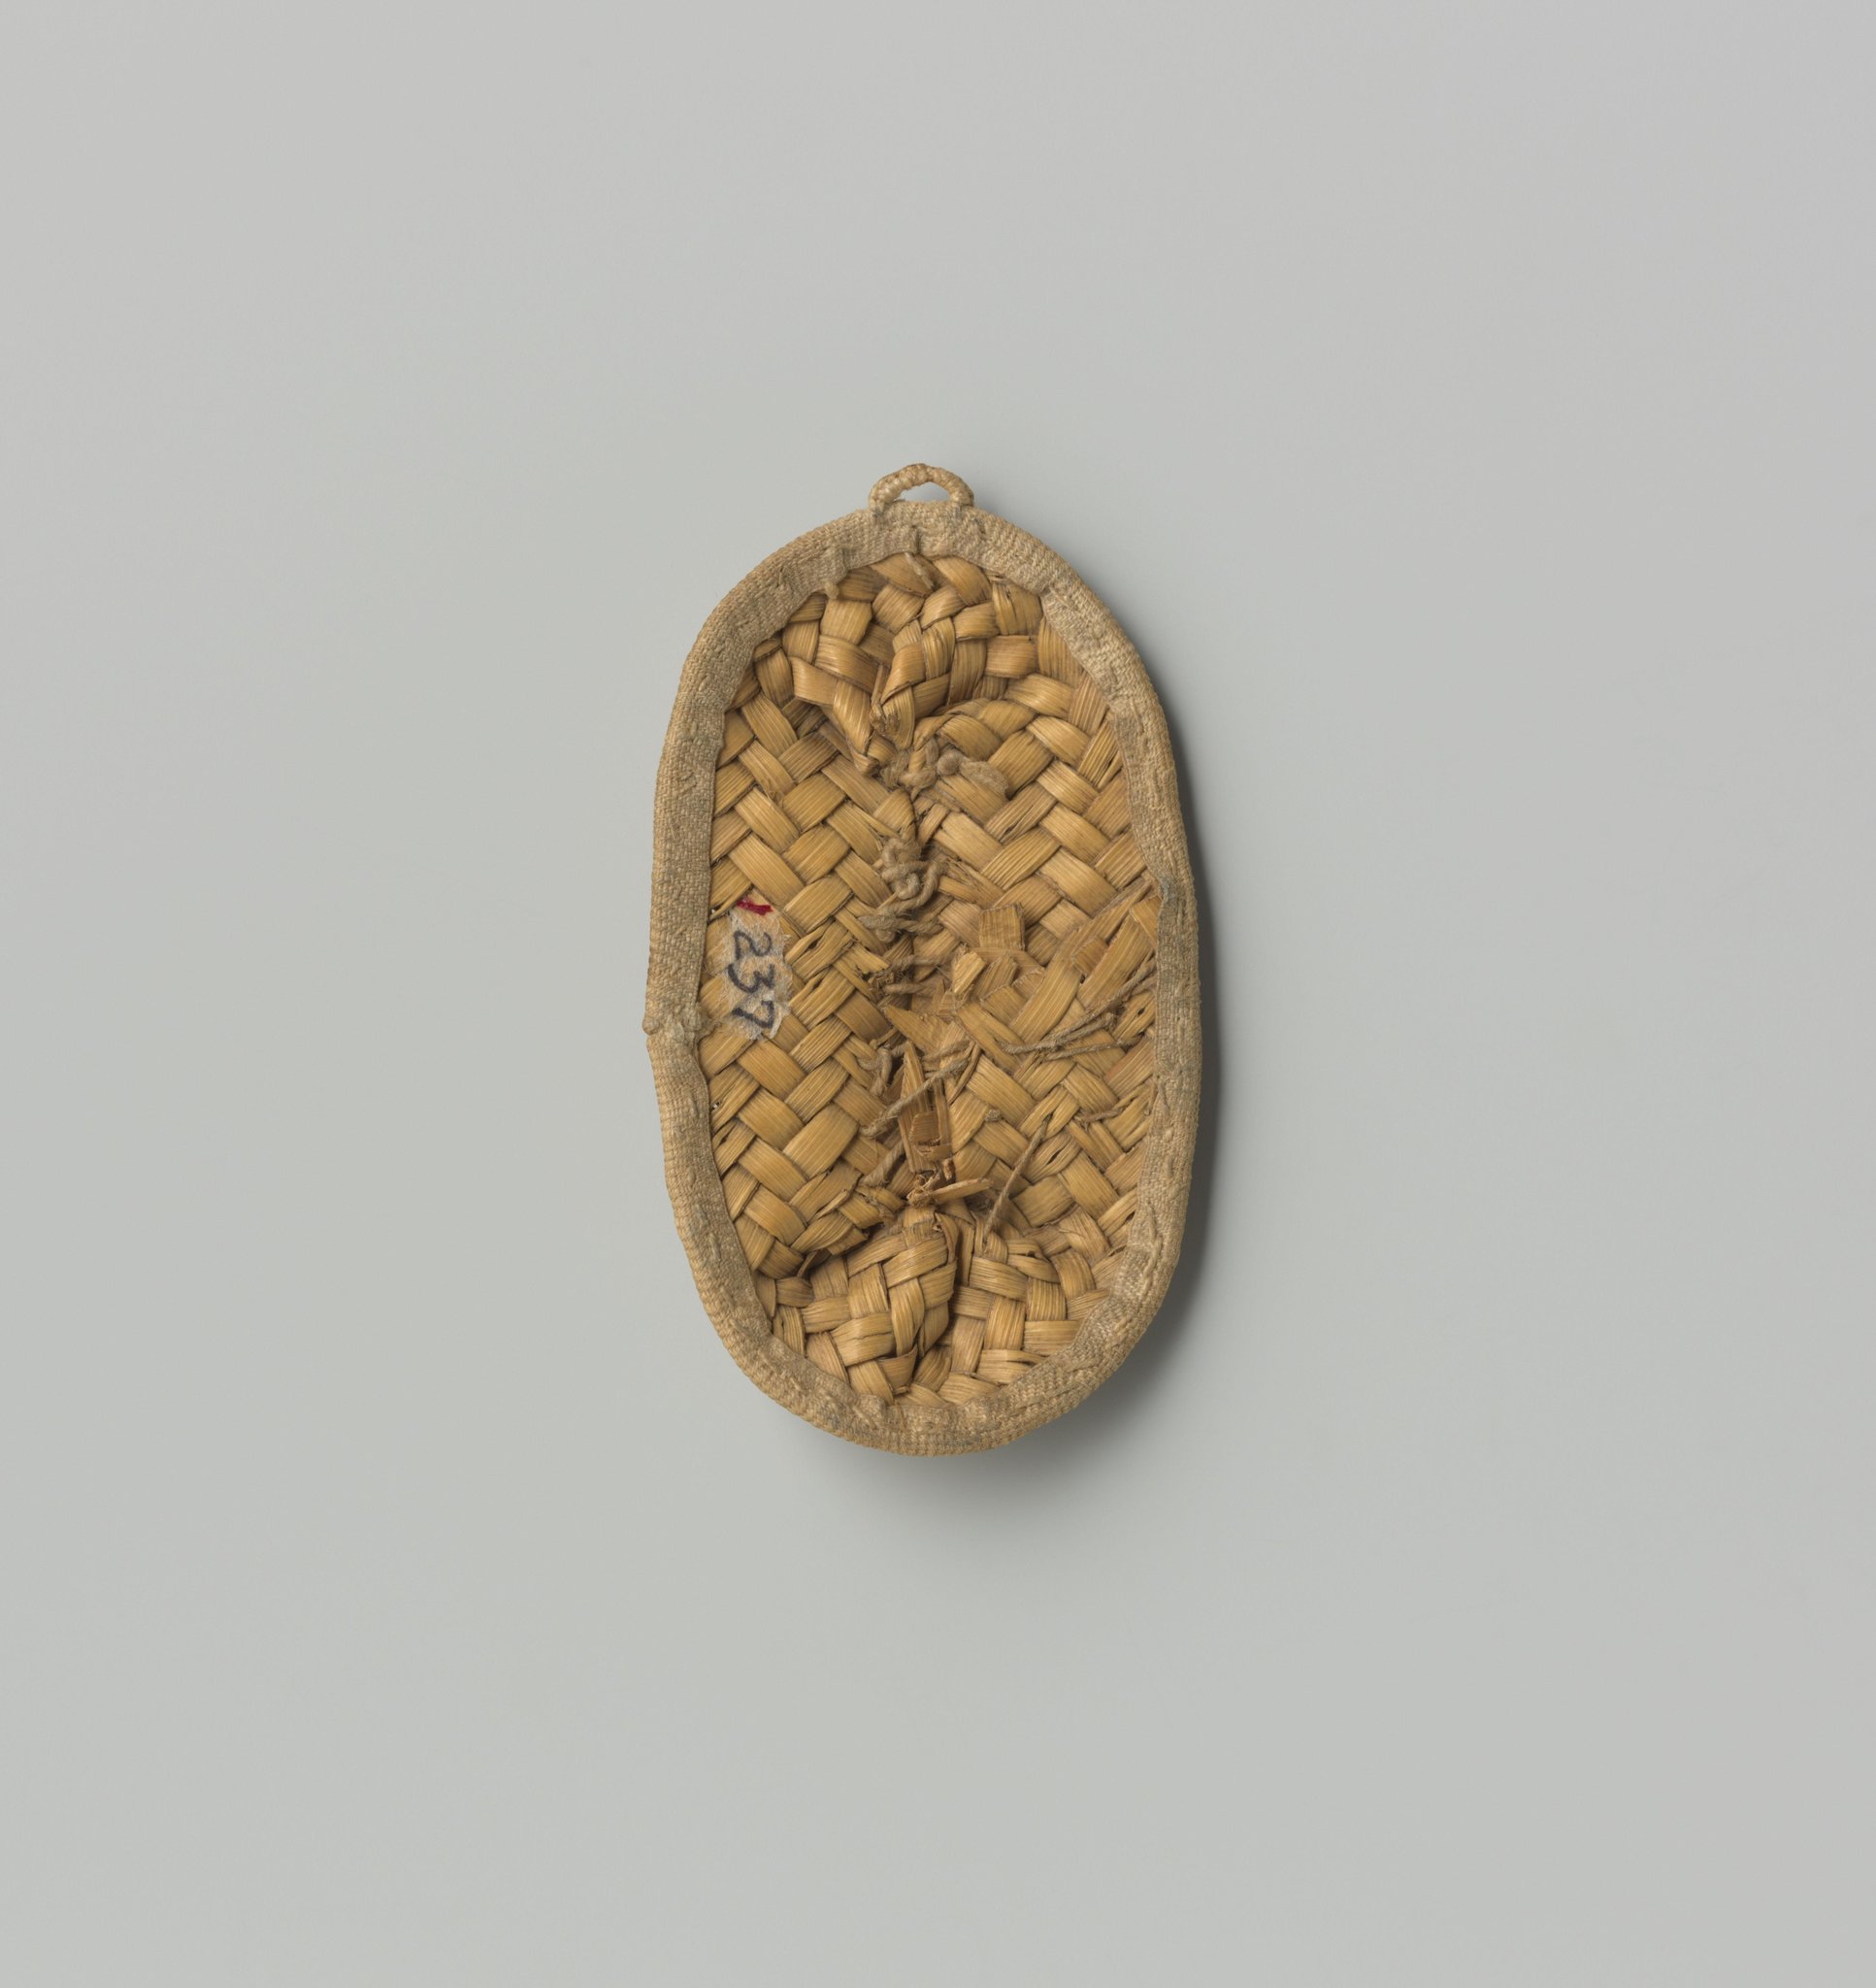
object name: mat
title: Ovaal vloermatje, vervaardigd van een strook gevlochten platte bies of stro, met rimpels in een ovaal gelegd en met touw bijeengenaaid; omzoomd met linnen band met lusje.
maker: Anonymous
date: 1675-1710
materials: plant fiber, linen, fiber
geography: halle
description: Ovale (vloer)matje, vervaardigd van een strook gevlochten platte bies of stro, met rimpels in een ovaal gelegd en met touw bijeengenaaid; omzoomd met linnen band met lusje.